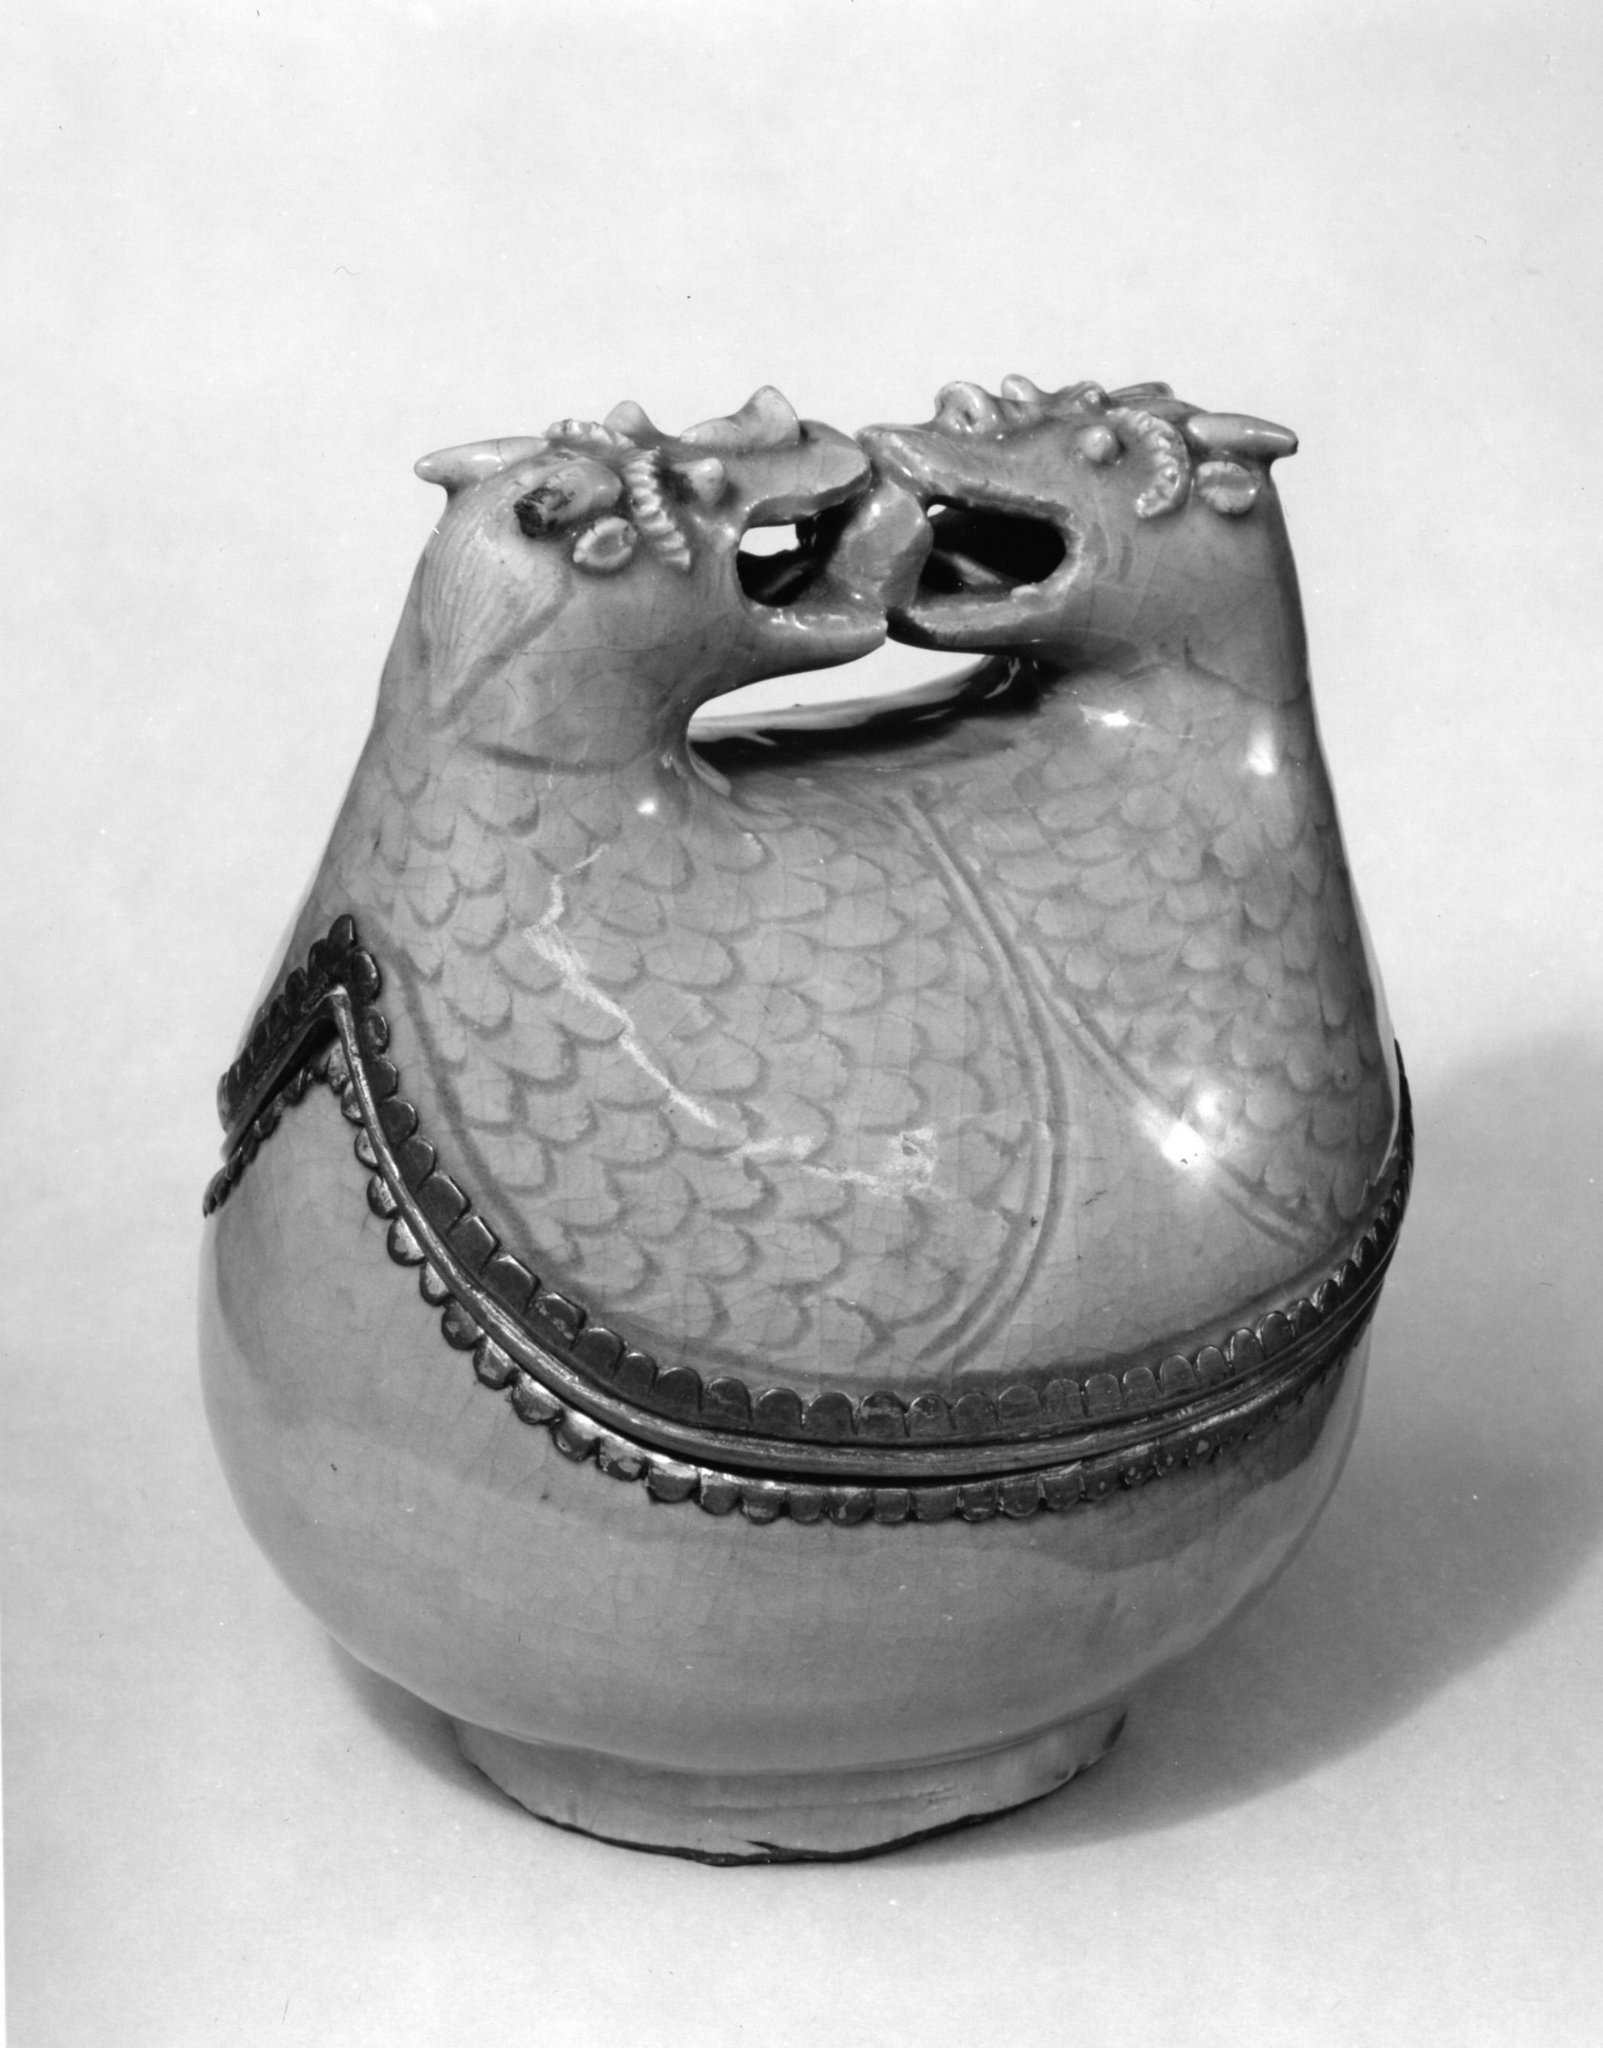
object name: vessel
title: Vessel in the Form of a Double Dragon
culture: thai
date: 1301-1500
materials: earthenware, silver gilt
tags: dragons